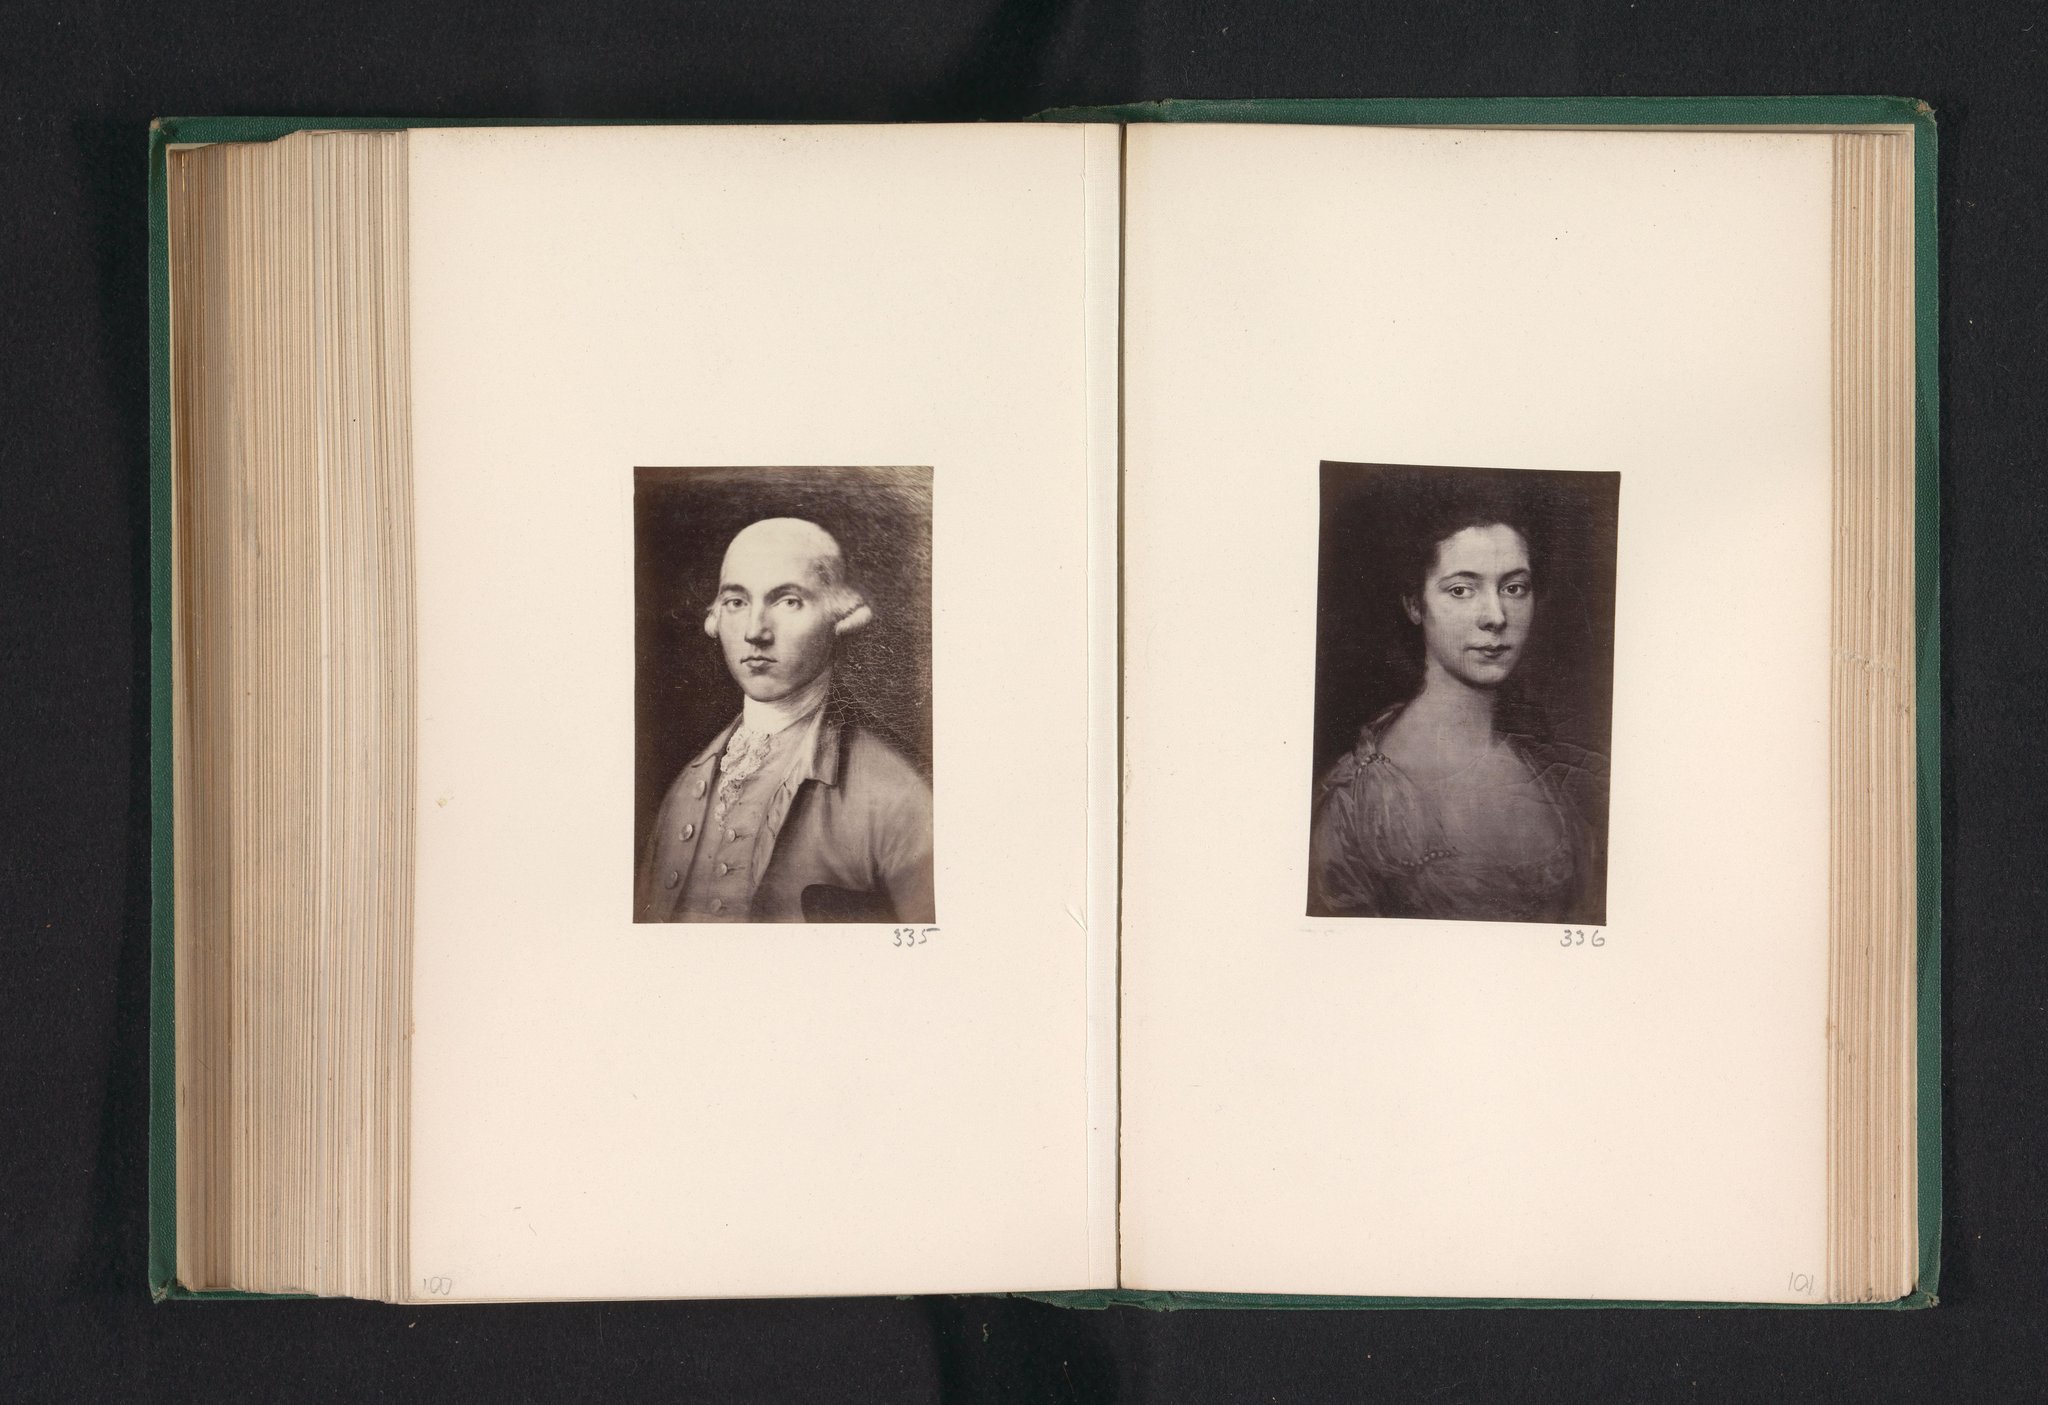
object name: reproduction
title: Fotoreproductie van een schilderij, voorstellende een portret van George Oswald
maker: thomas annan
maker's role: fotograaf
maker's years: 1829-1887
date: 1863-1868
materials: photographic support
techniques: albumen print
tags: anonymous historical person portrayed (+ (full) bust portrait)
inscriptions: number: ‘335’